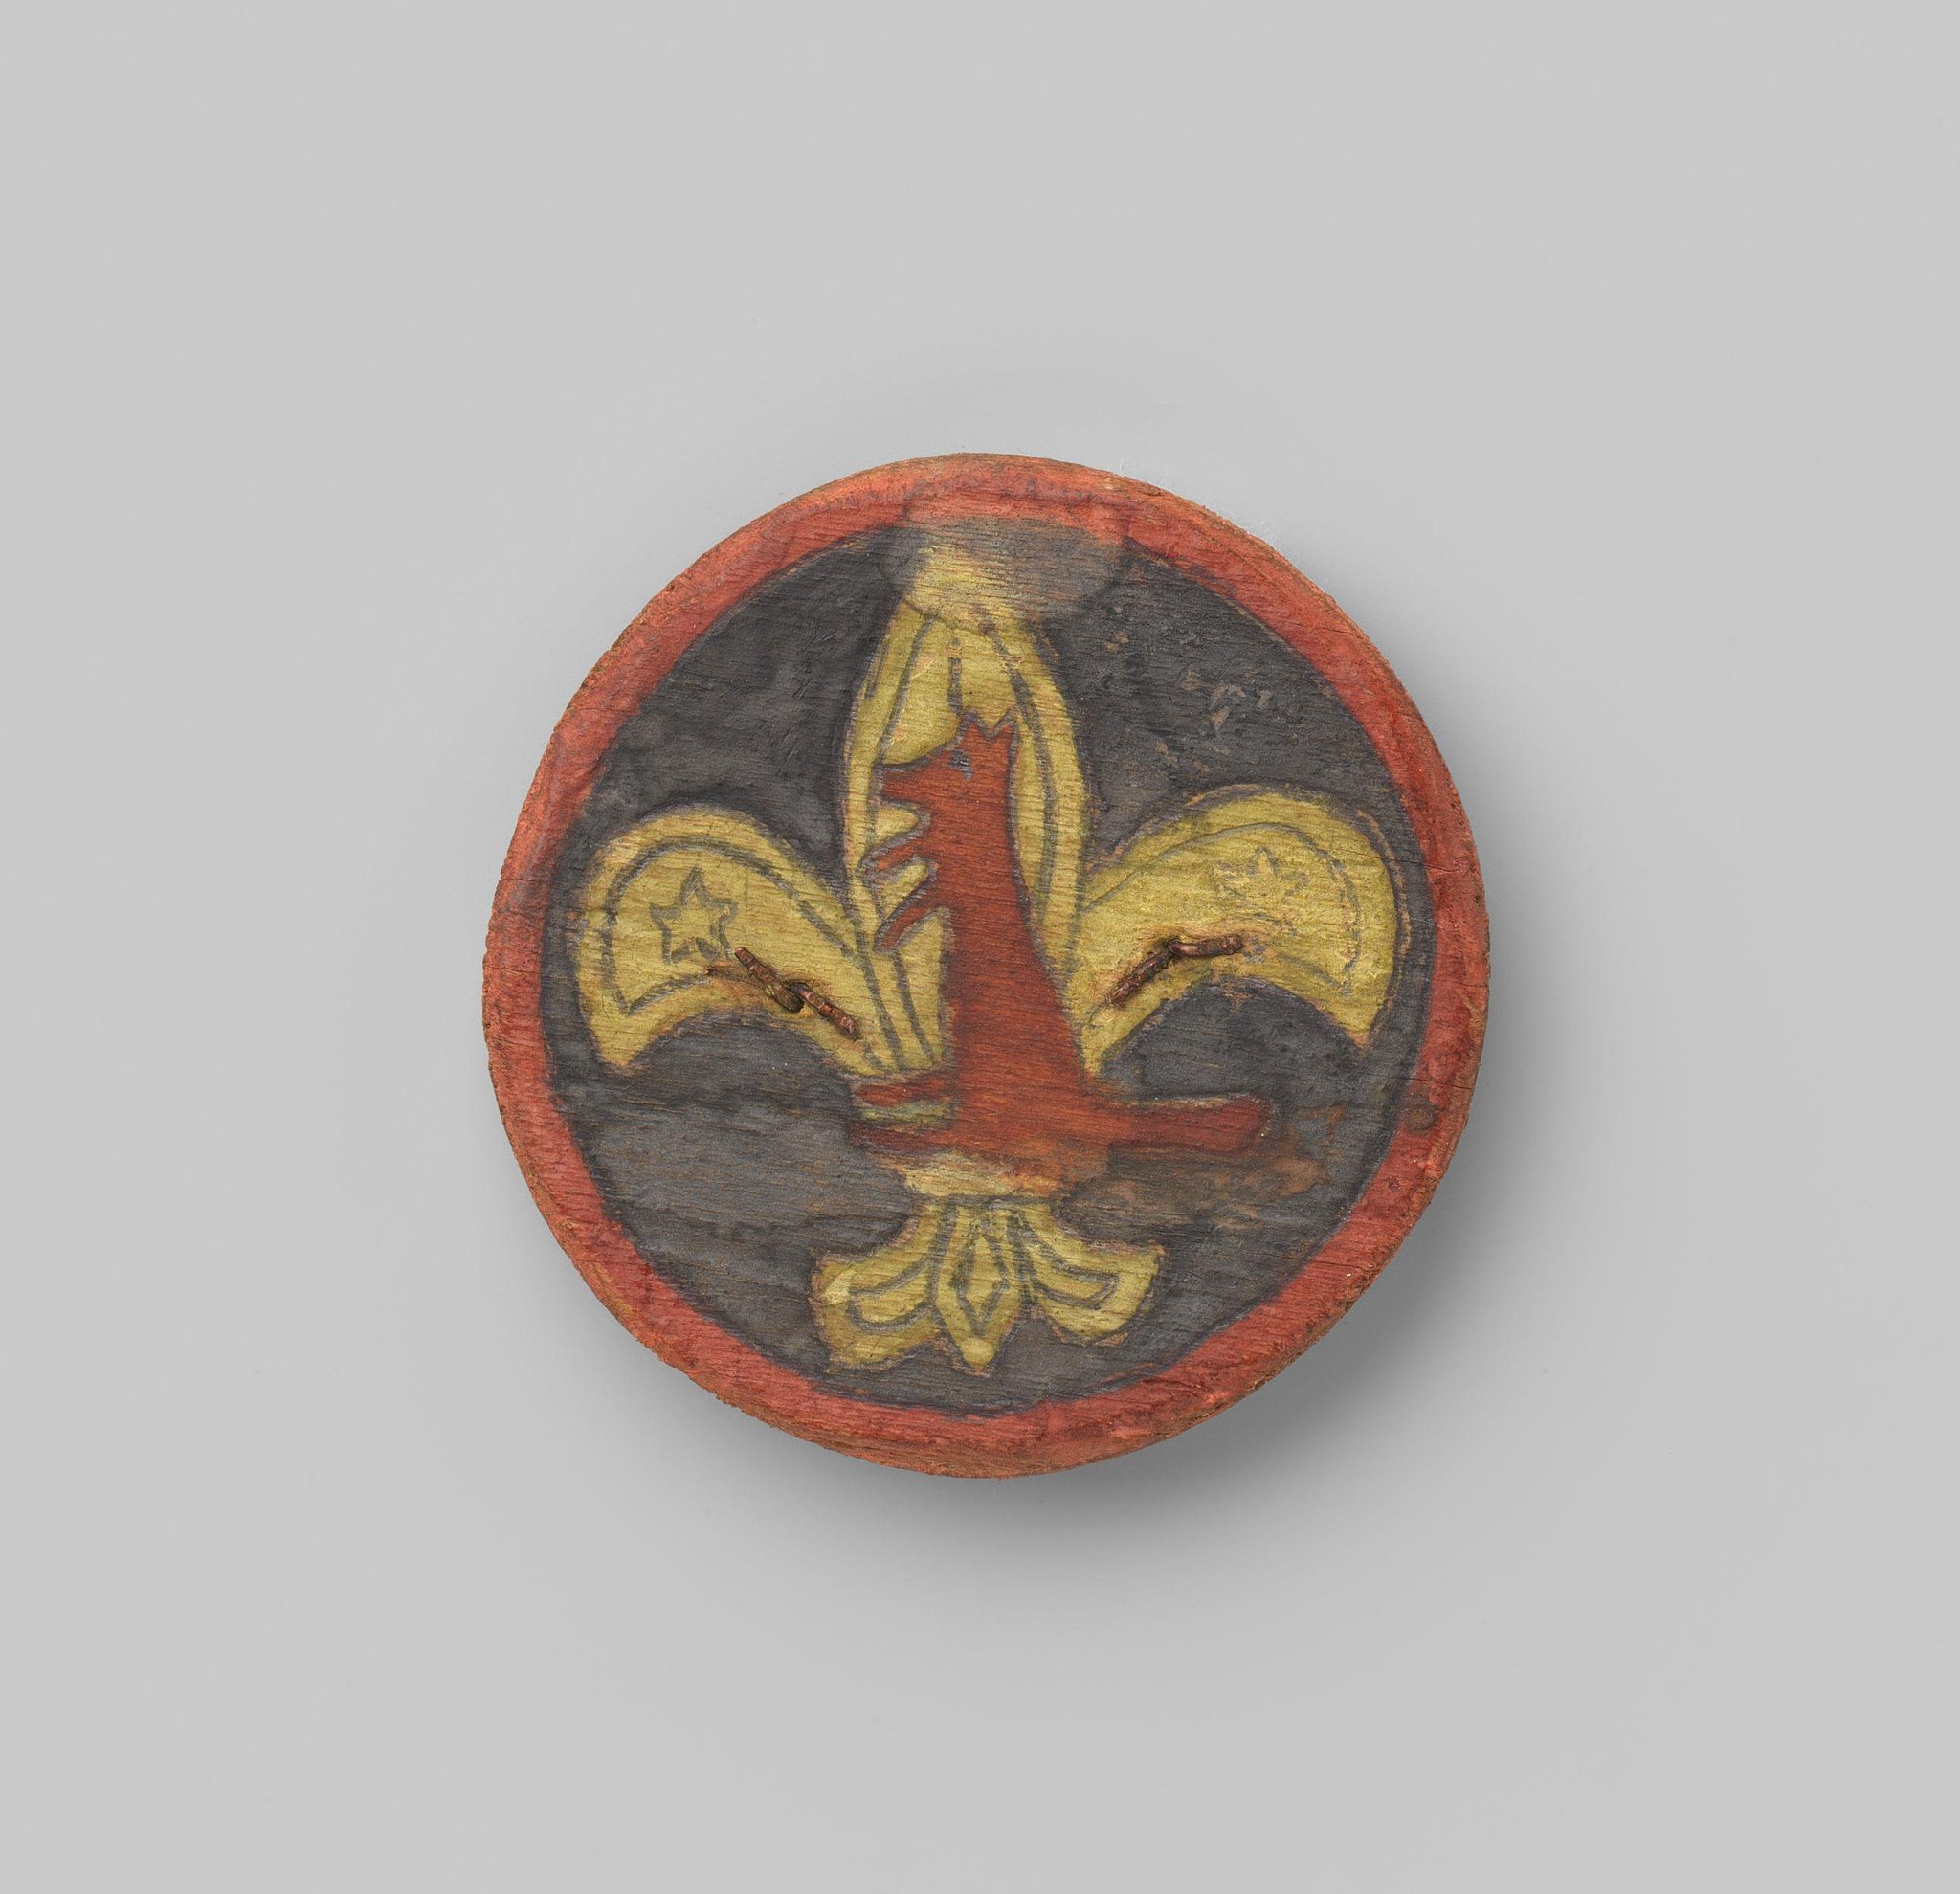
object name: insignia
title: Patrouille-insigne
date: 1945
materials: metal, paint